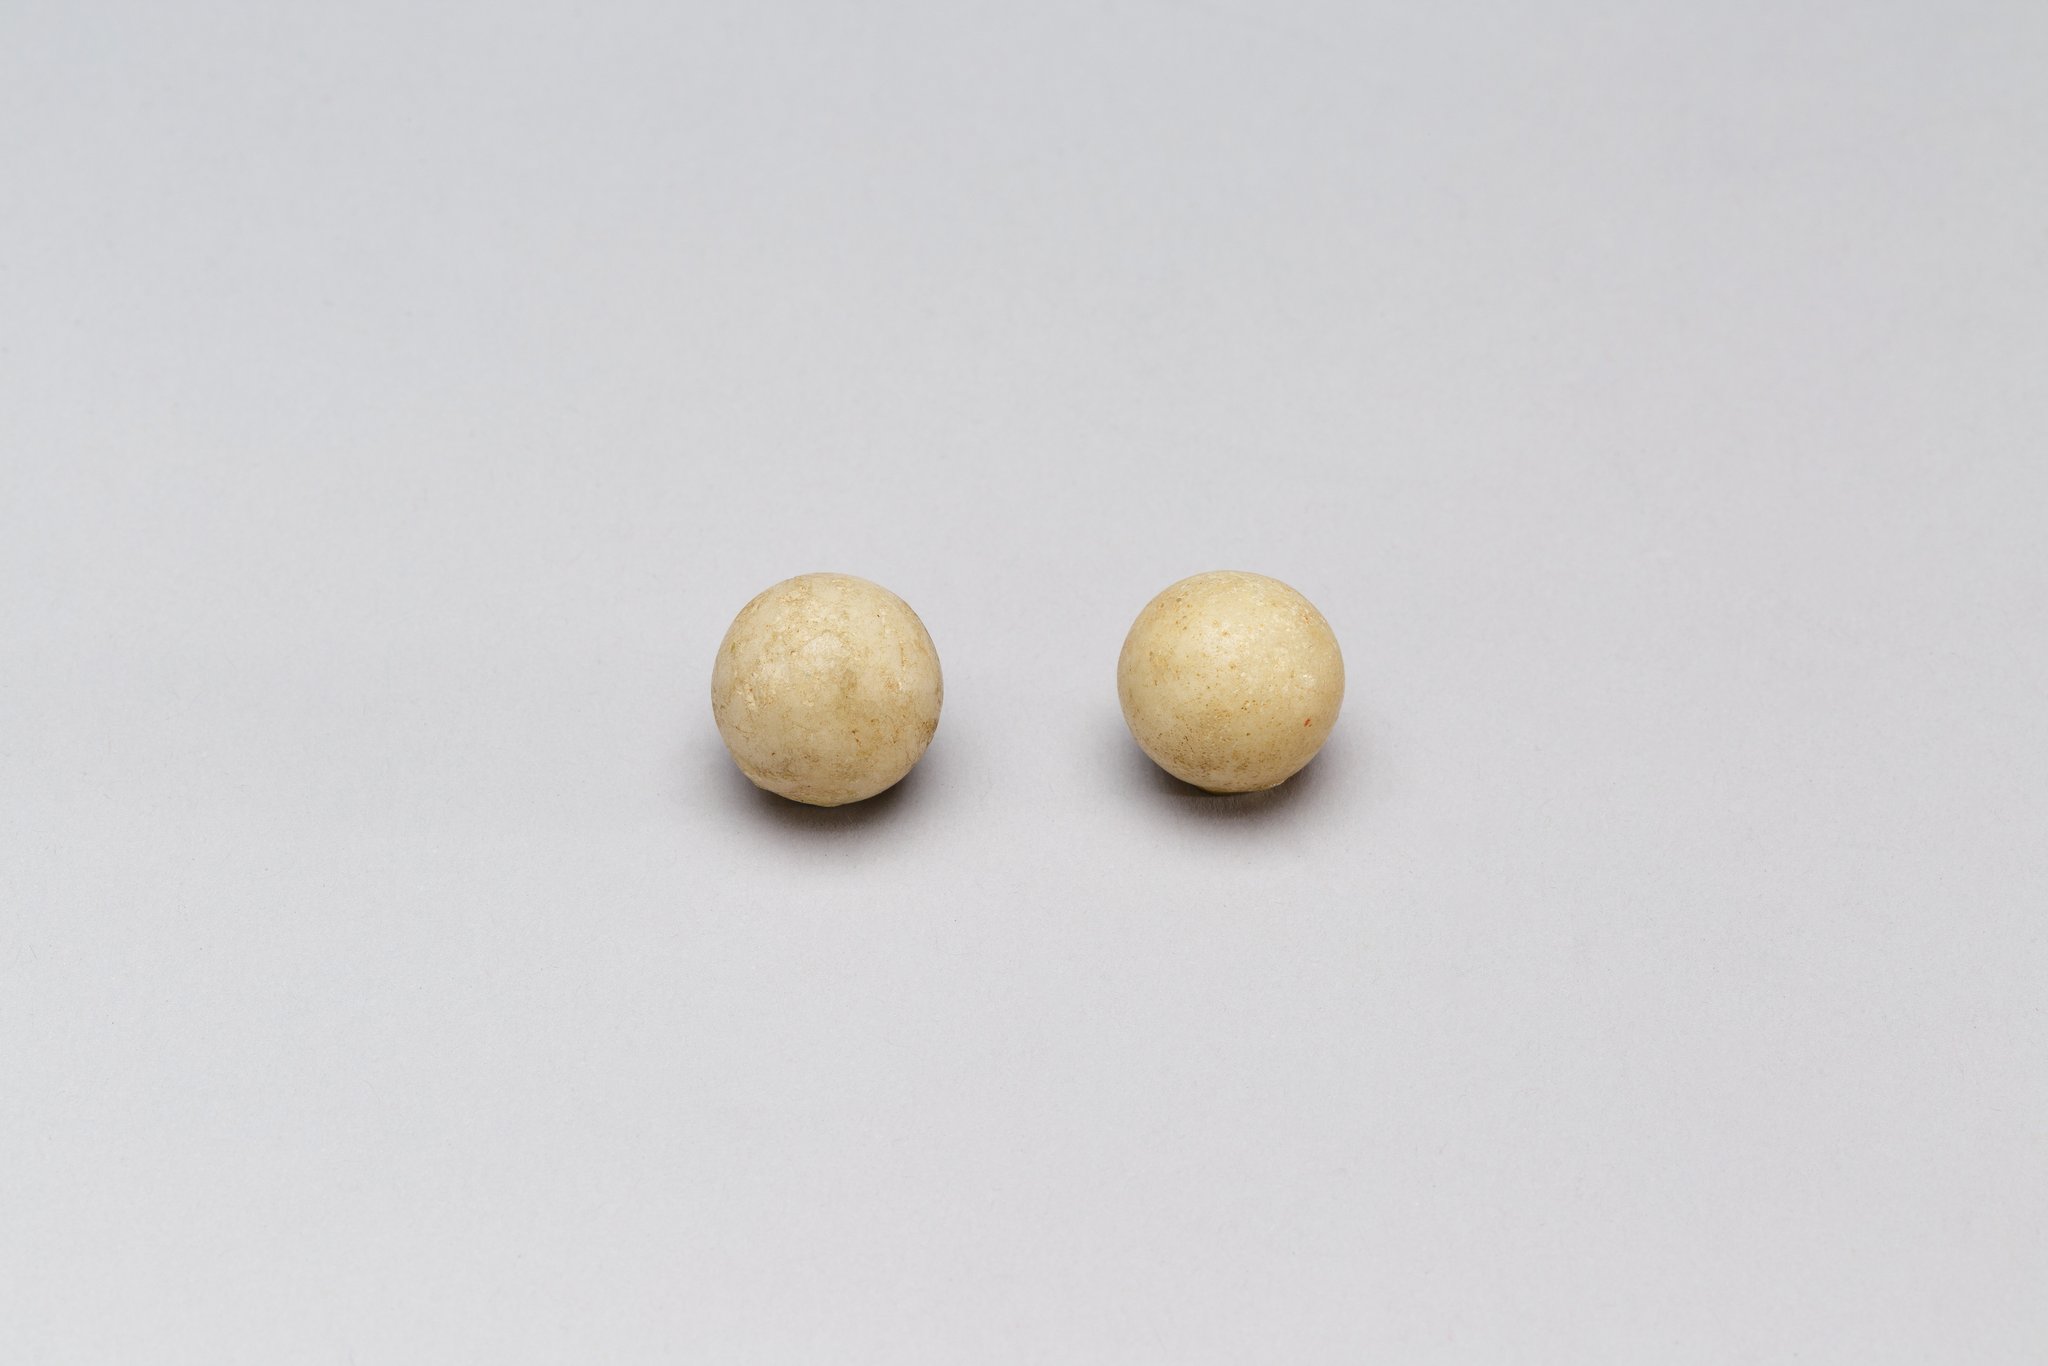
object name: game piece, marble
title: Marble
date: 3850-2300 BCE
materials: stone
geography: egypt